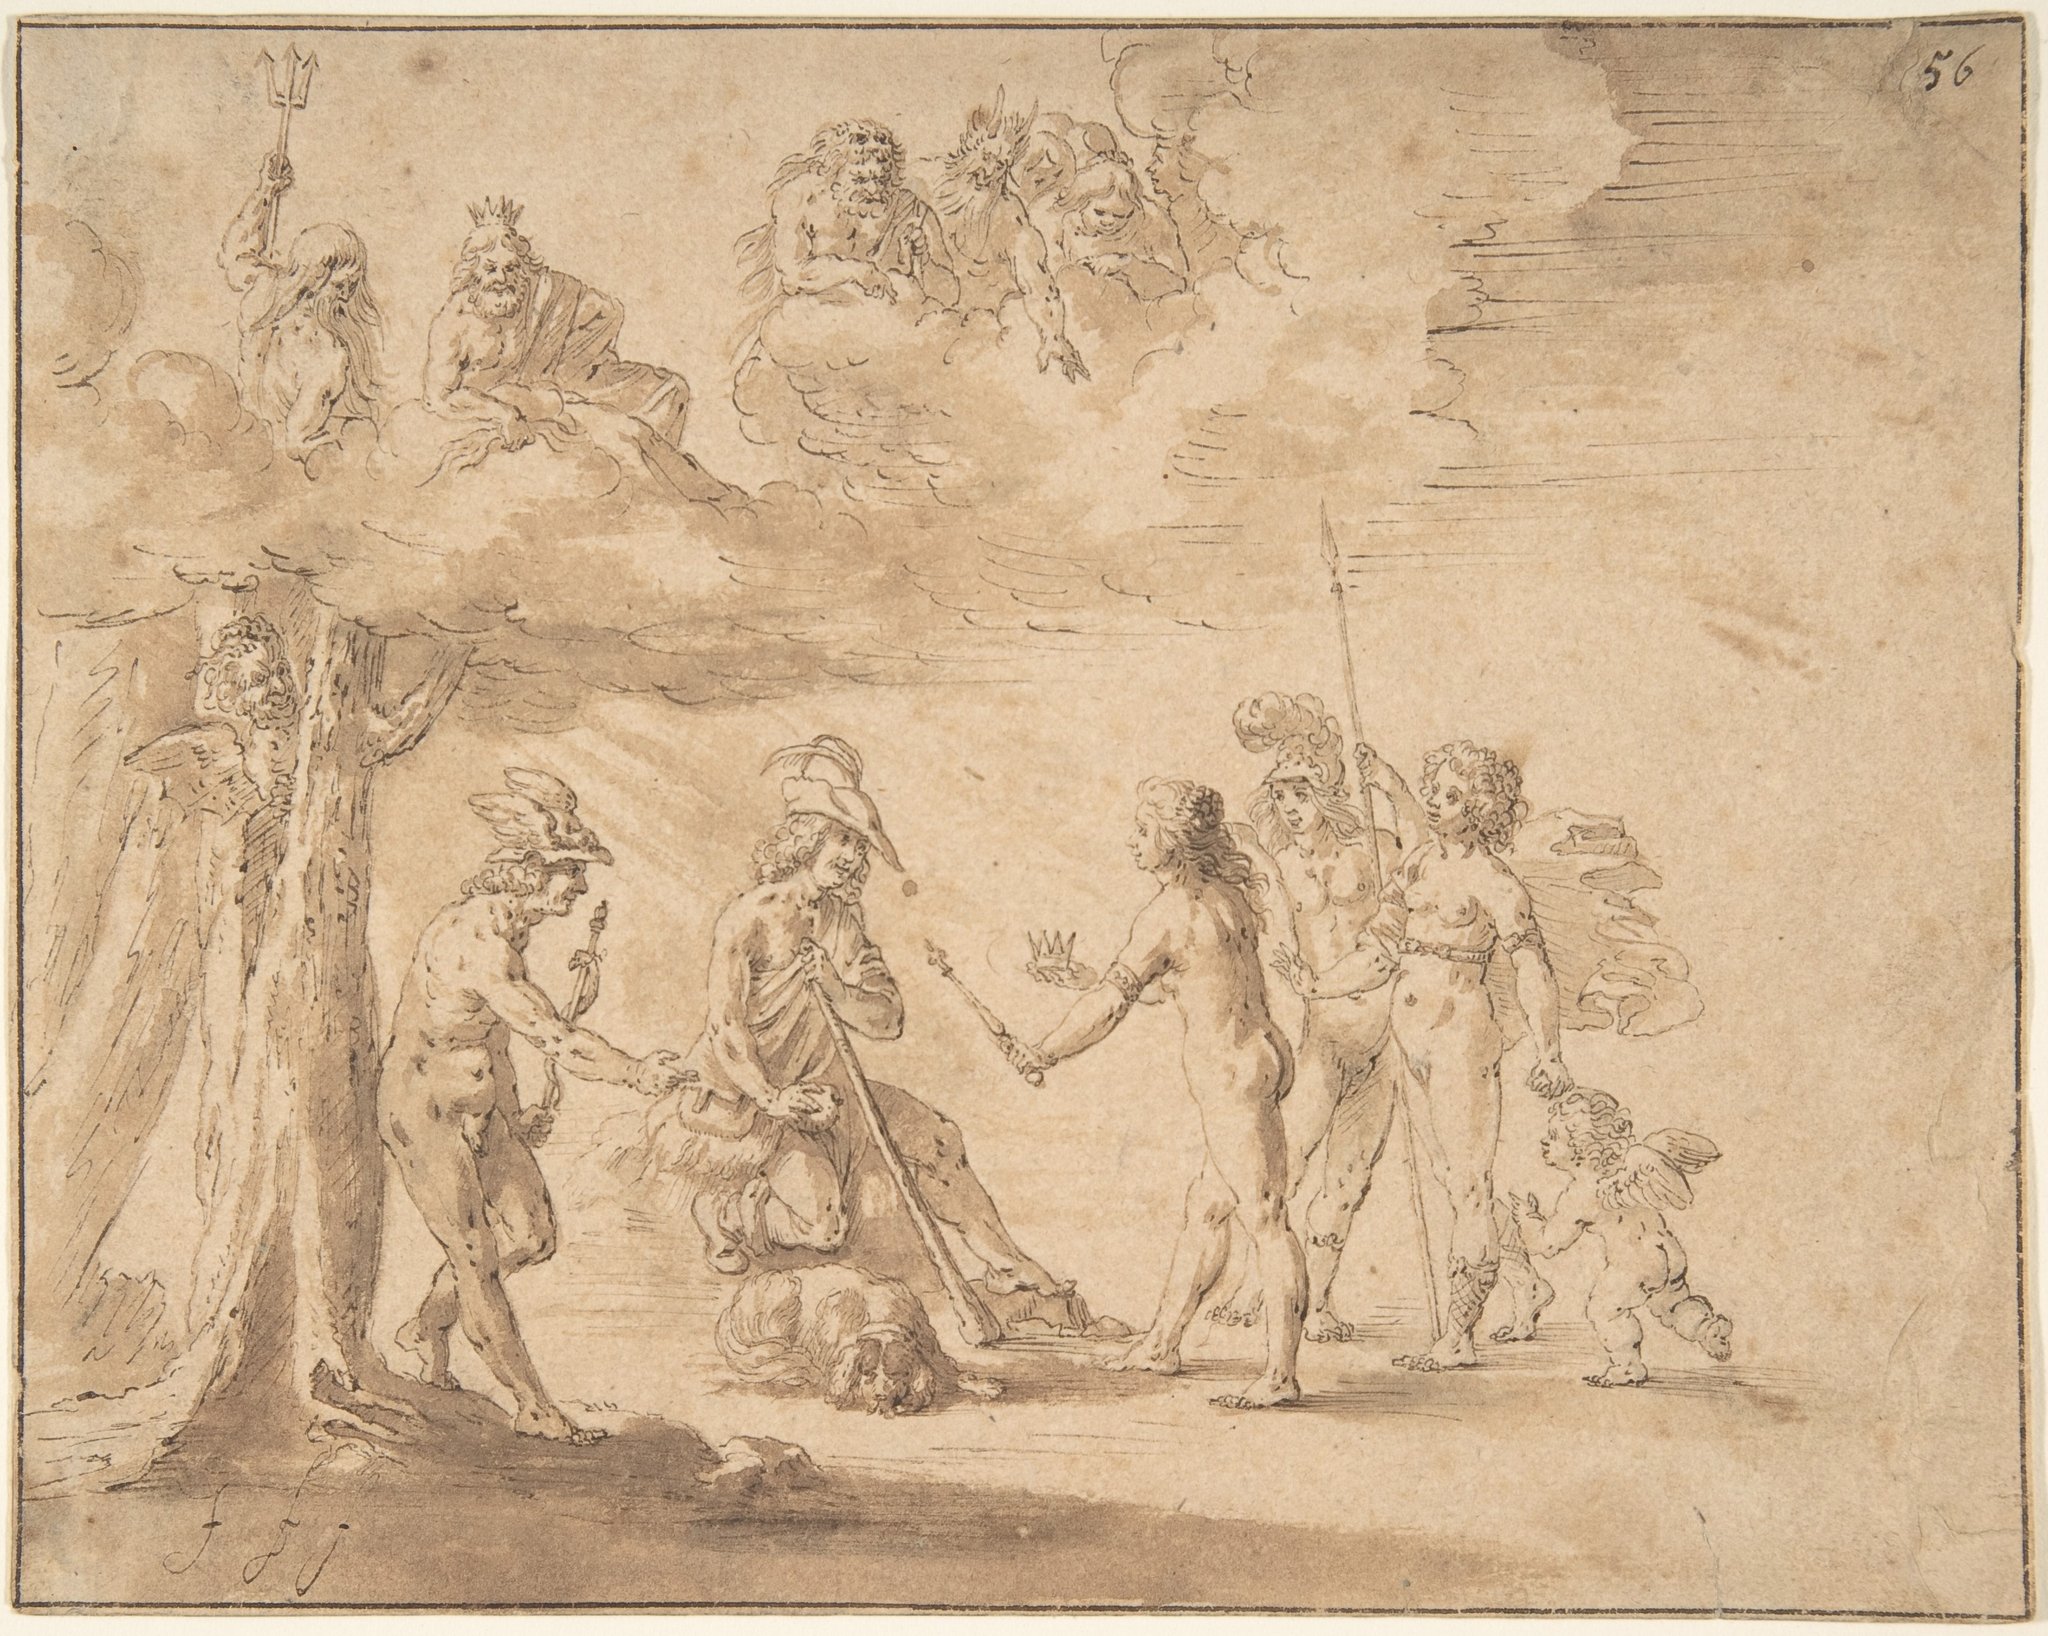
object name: drawing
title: Judgment of Paris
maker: anonymous, dutch, 17th century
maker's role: artist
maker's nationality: dutch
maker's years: 1600-1700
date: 1601-1700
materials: ink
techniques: brush, pen, wash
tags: male nudes,female nudes